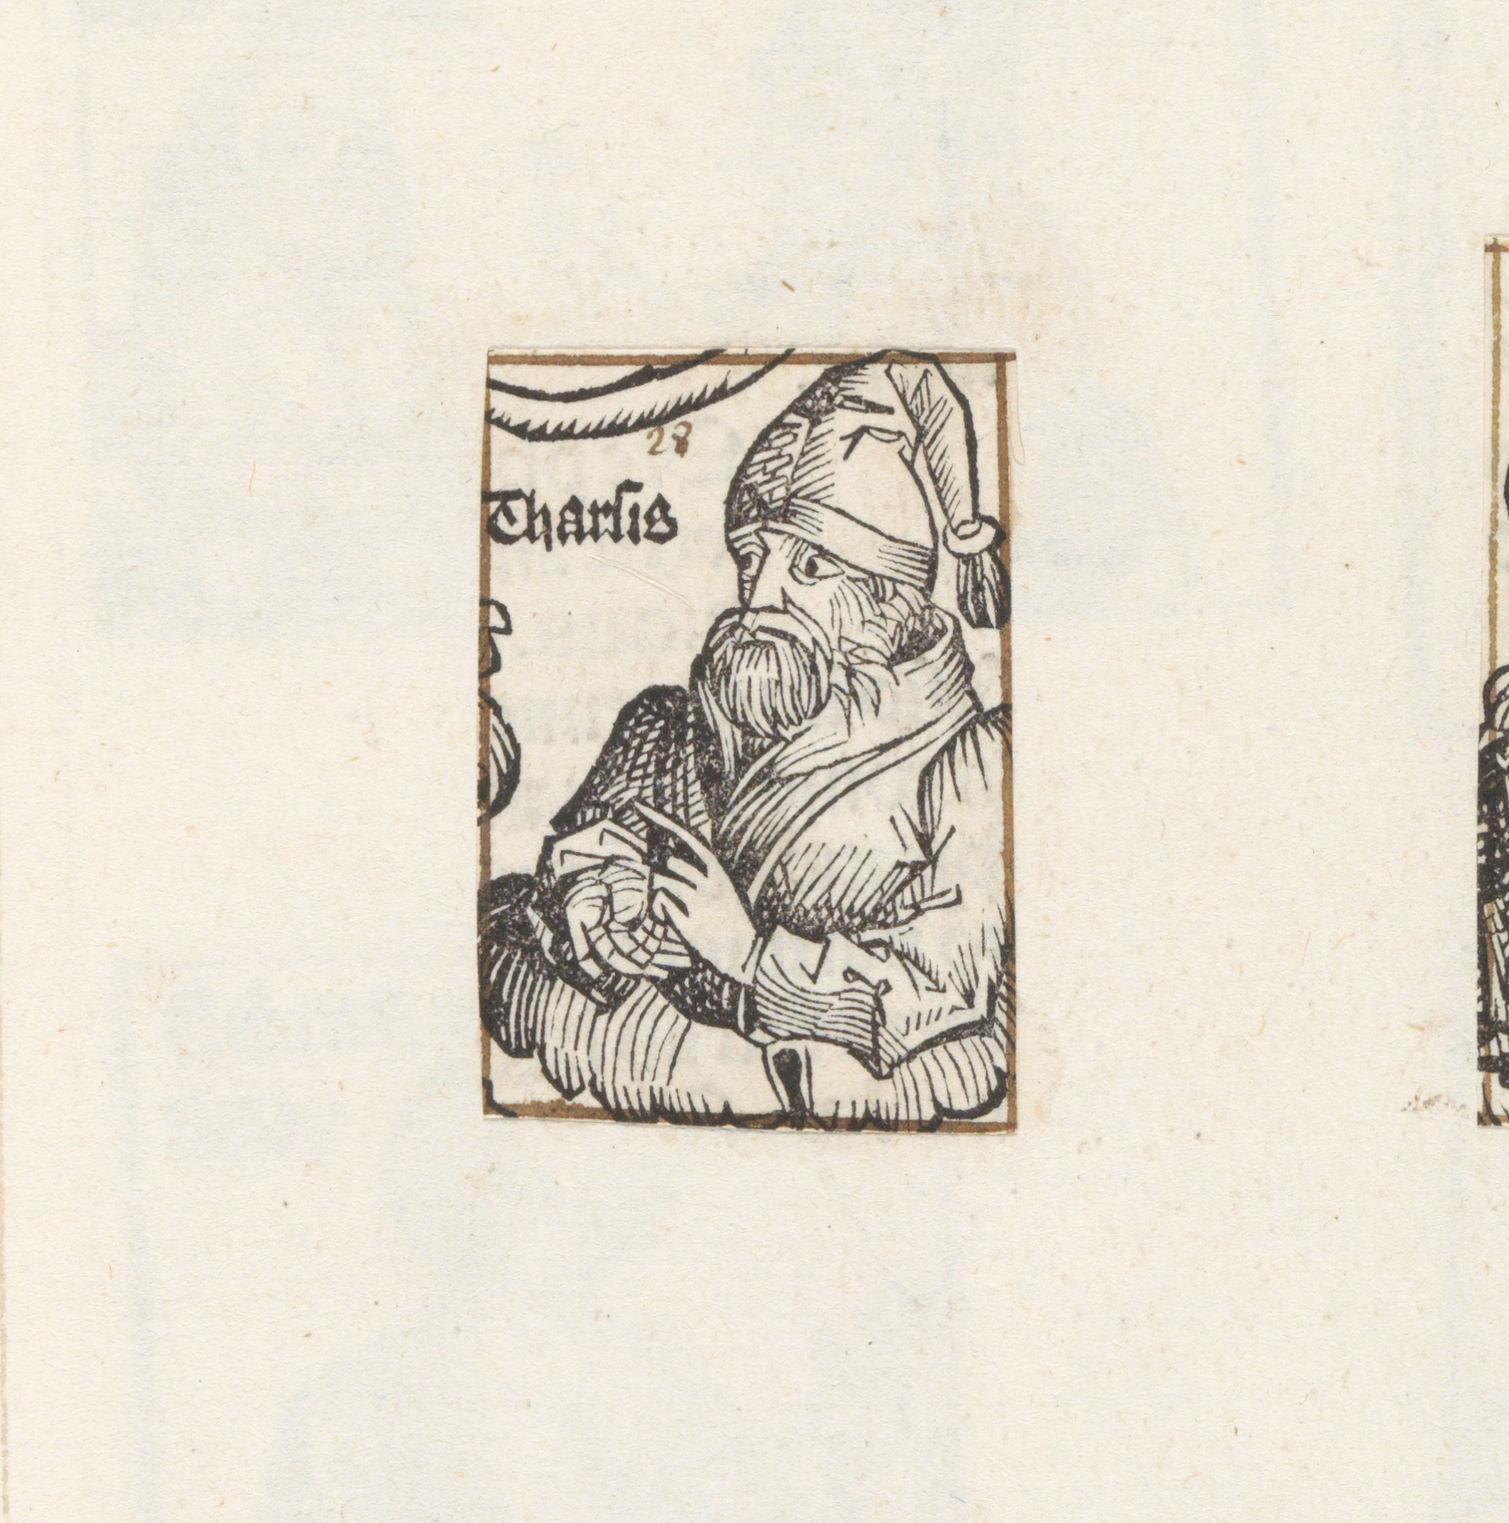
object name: book illustration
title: Tharsis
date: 1493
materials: paper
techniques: letterpress printing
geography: nuremberg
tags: persons from the old testament (not in biblical context, nor occurring in legendary/historical extensions included in division 71)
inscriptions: inscription: ‘28’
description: Een bloemkelk met een man met een muts op het hoofd, naar links gekeerd en geïdentificeerd als Tarsis, een zoon van Jawan. De voorstelling is een fragment van de stamboom van Christus in de Liber Chronicarum. De prent maakt deel uit van een album.